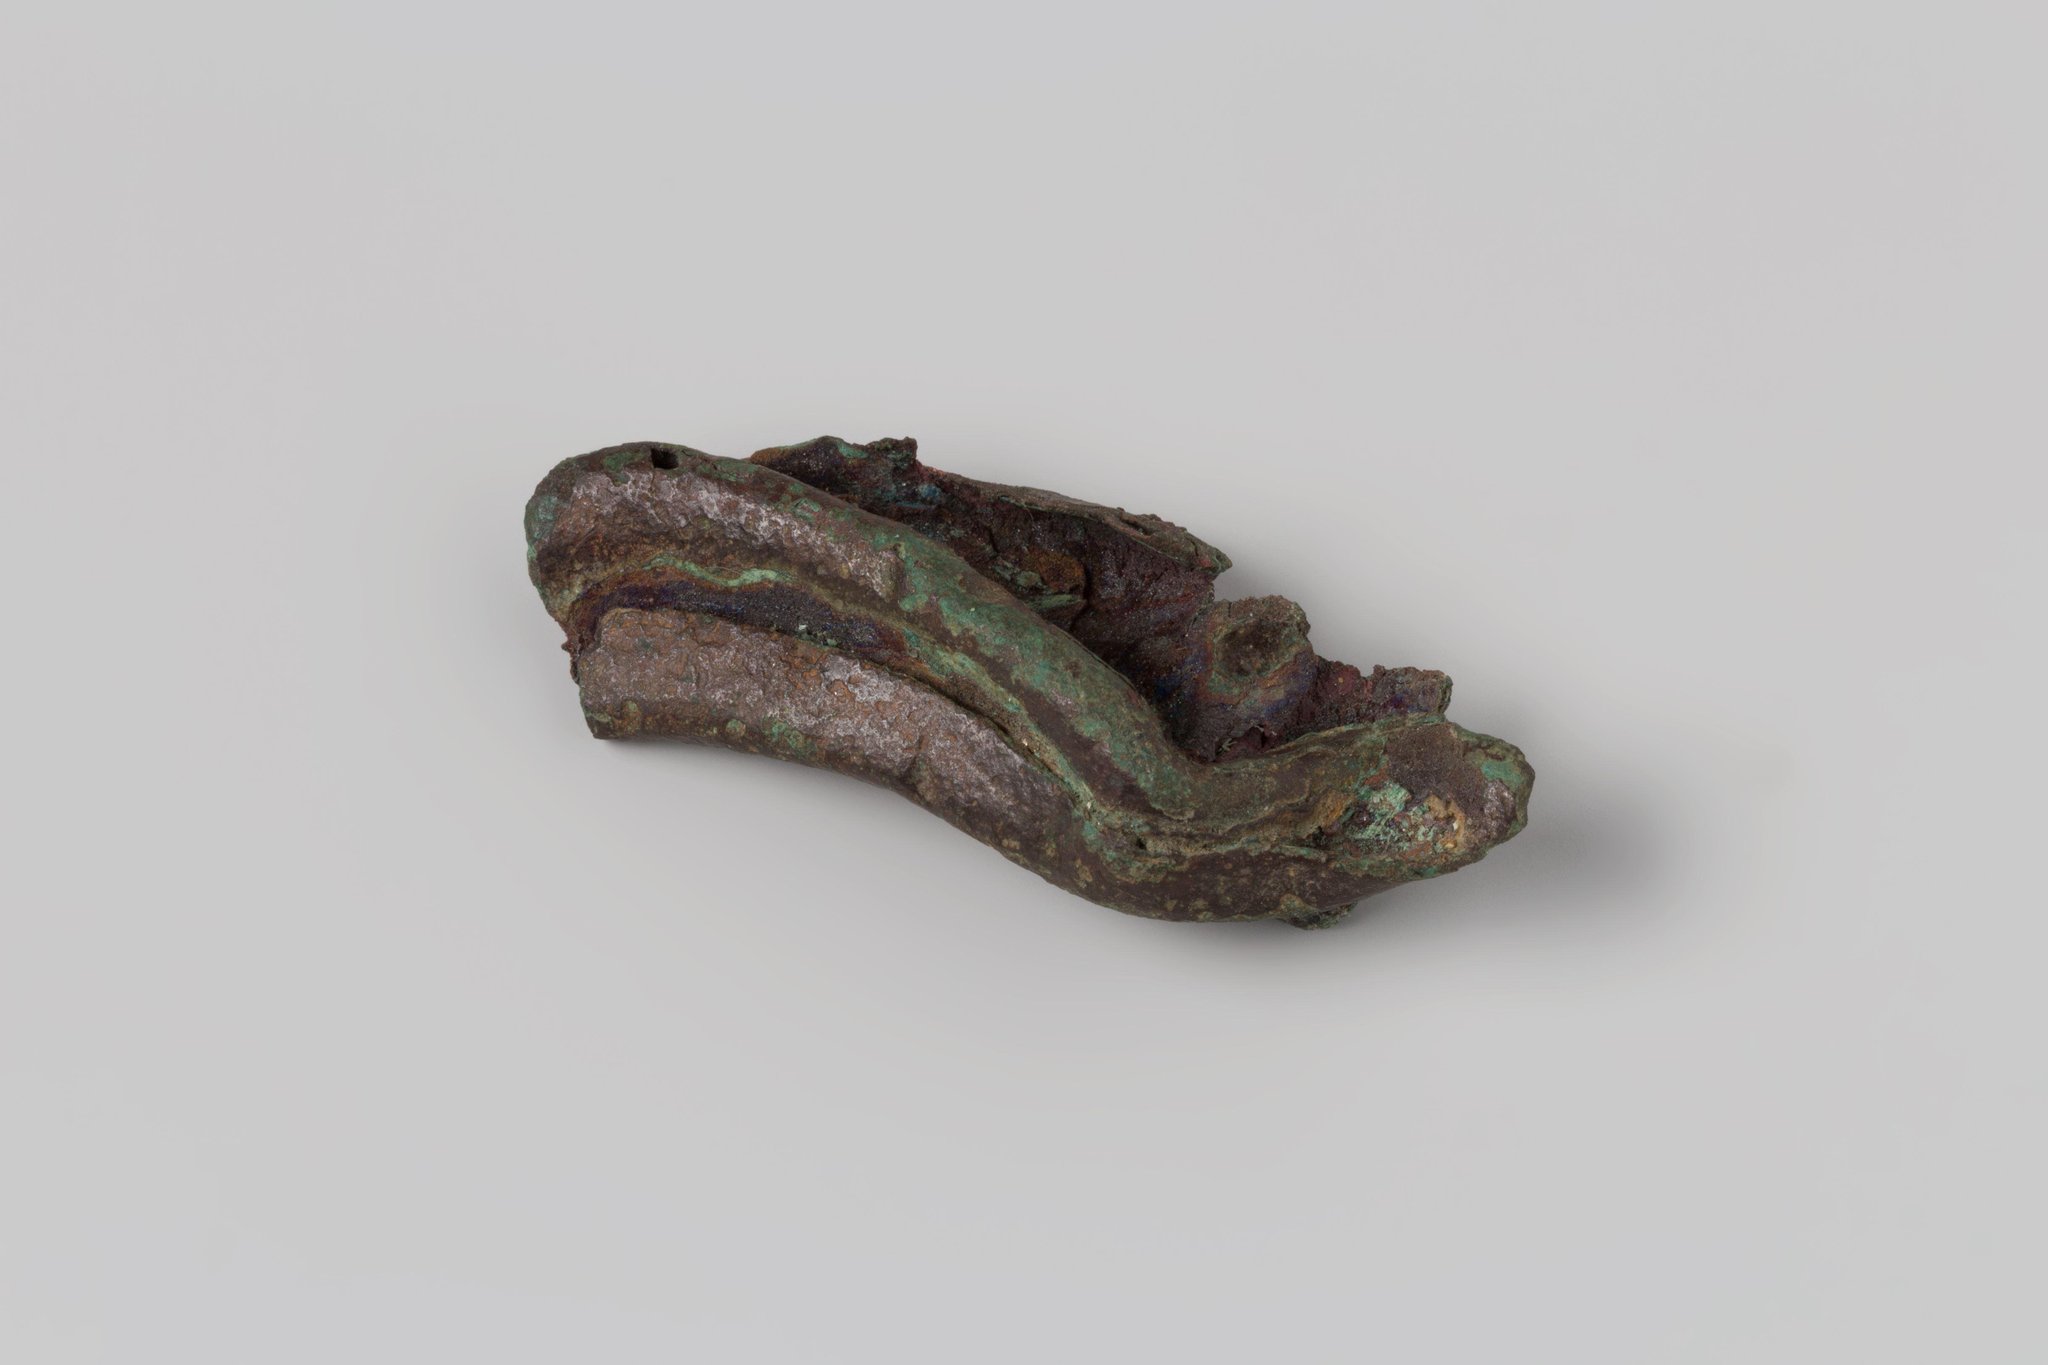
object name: scheepswrakvondst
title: Fragment van koper uit het wrak van de Oost-Indiëvaarder Hollandia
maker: Anonymous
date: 1700-1743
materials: copper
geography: netherlands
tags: verenigde oostindische compagnie, hollandia (schip), annet